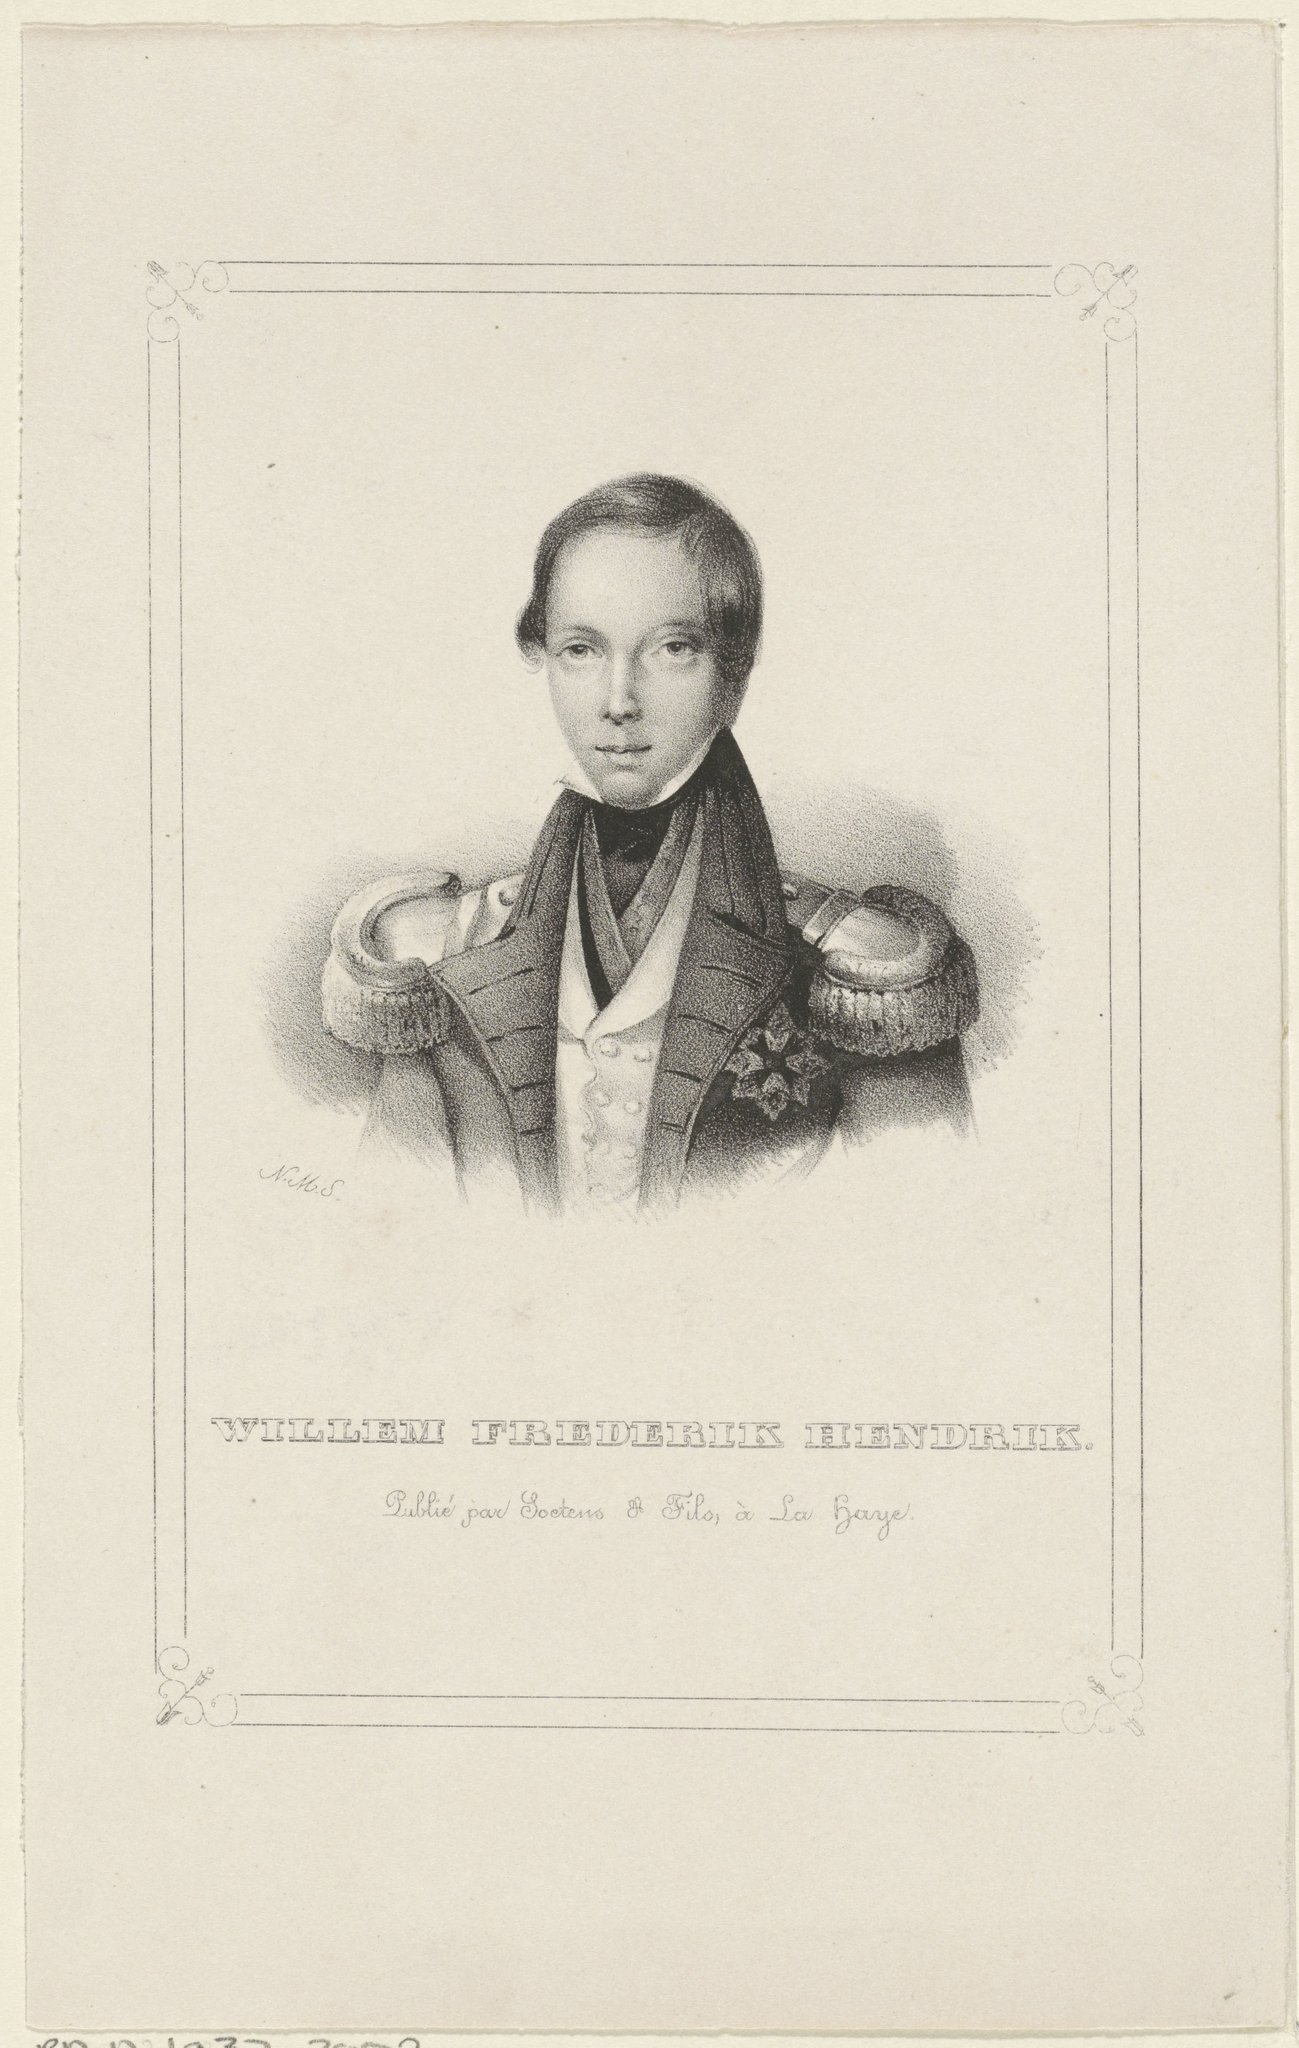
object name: print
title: Portret van Hendrik, prins der Nederlanden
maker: nicolaas martinus schild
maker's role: draughtsman, print maker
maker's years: 1822-1840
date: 1837-1840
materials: paper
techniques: lithograph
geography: the hague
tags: hendrik (prins der nederlanden)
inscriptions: collector's mark: Lugt 2228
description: De hier vermelde titel verwijst naar de hoogst verkregen titel van de geportretteerde, niet per se naar de titel die de geportretteerde op deze voorstelling draagt.